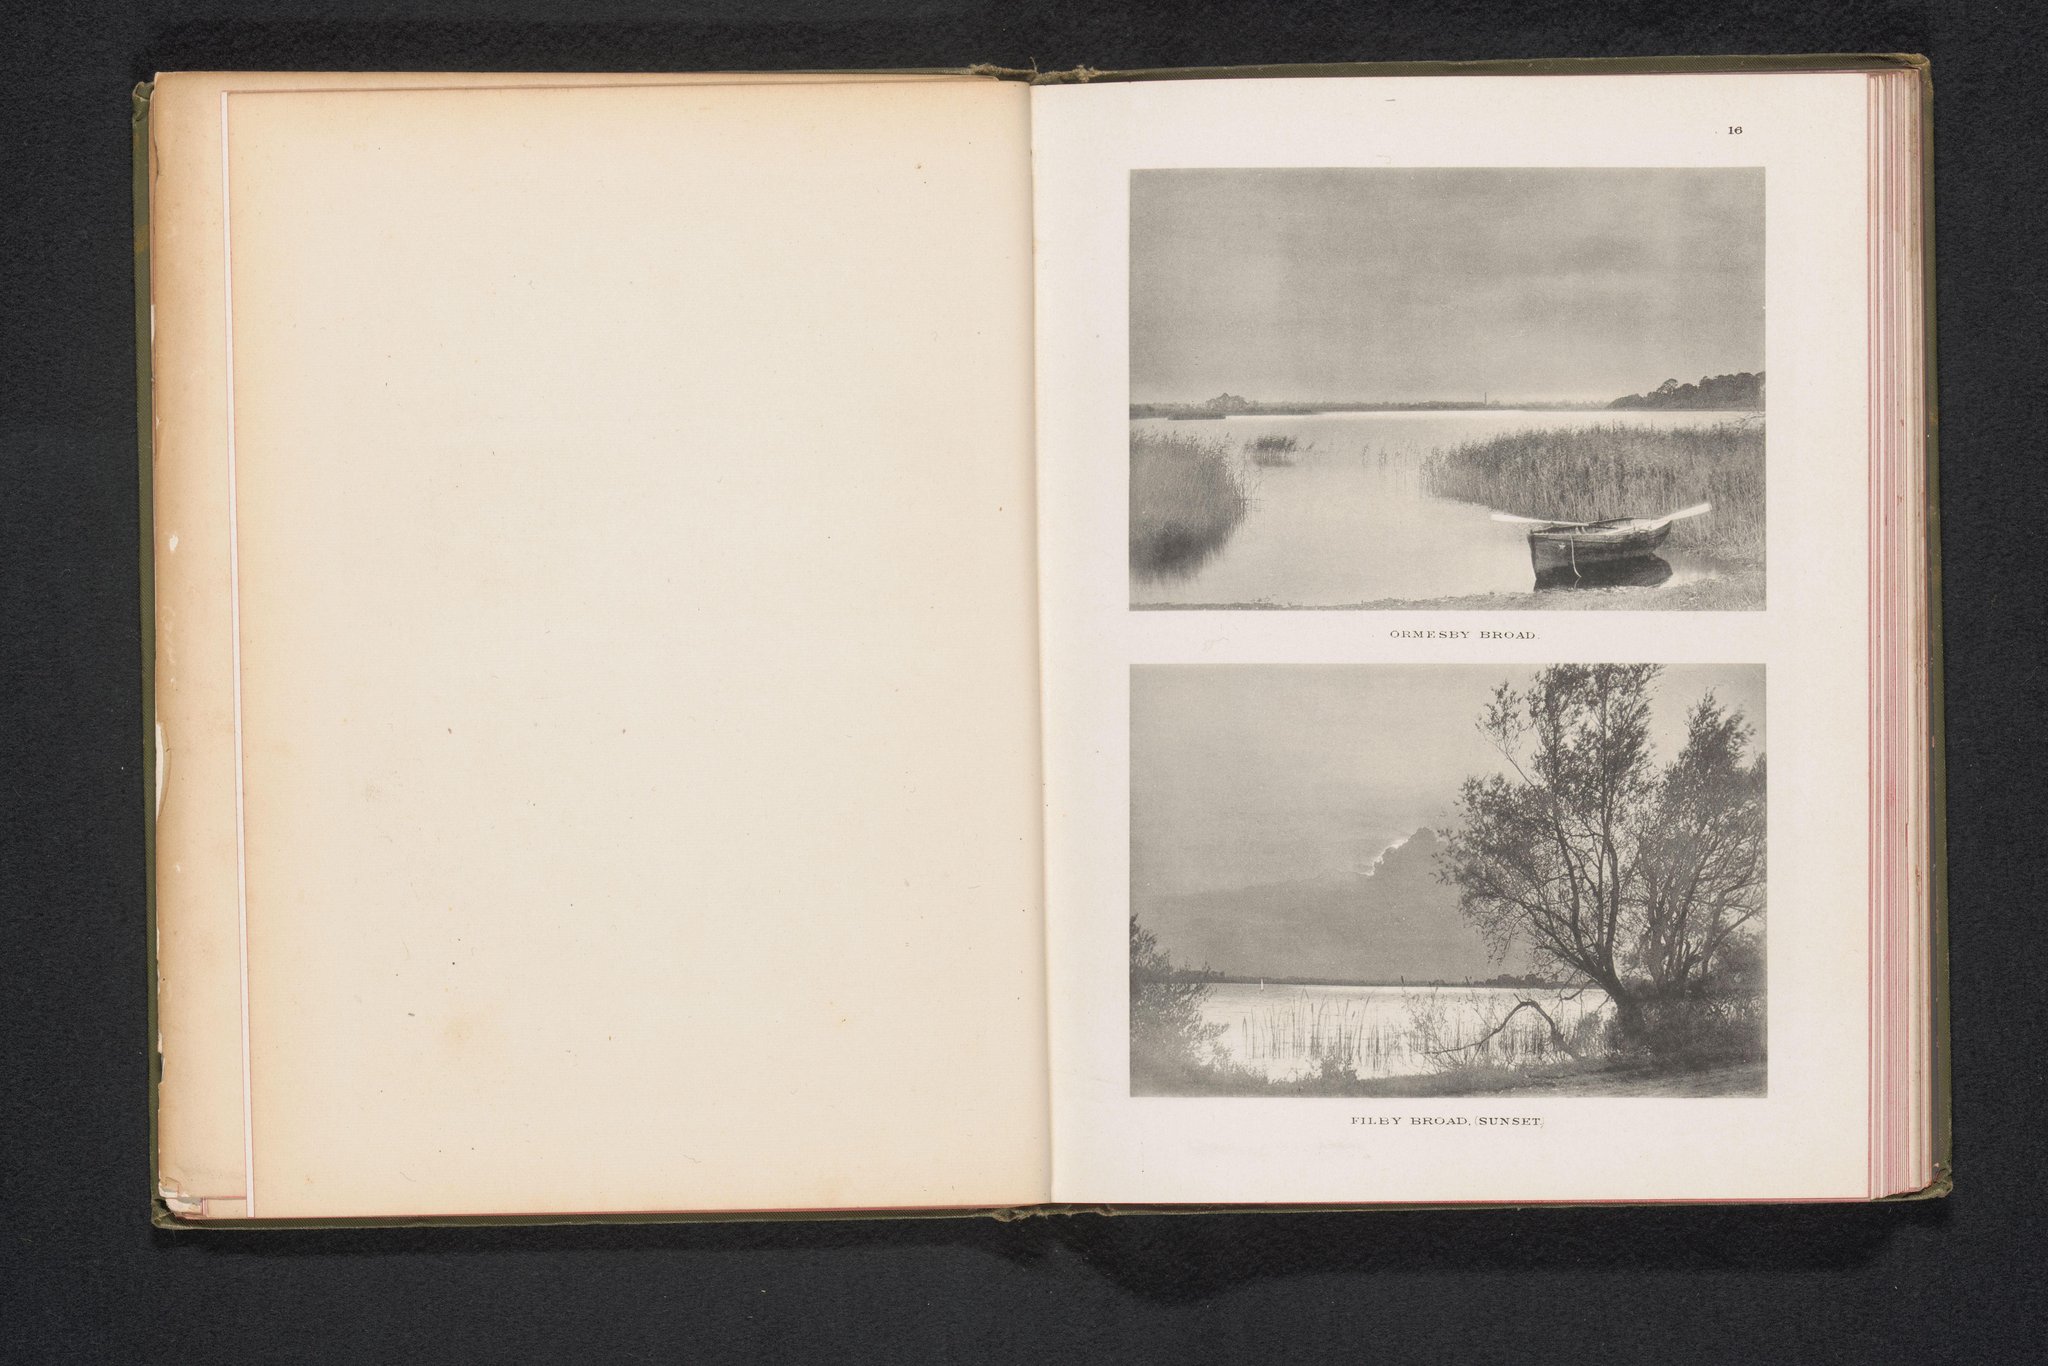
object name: page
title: Gezicht op Ormesby Broad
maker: john payne jennings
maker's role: fotograaf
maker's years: 1843-1926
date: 1886-1891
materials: paper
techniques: photograph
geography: norfolk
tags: rowing-boat, canoe, etc., lake